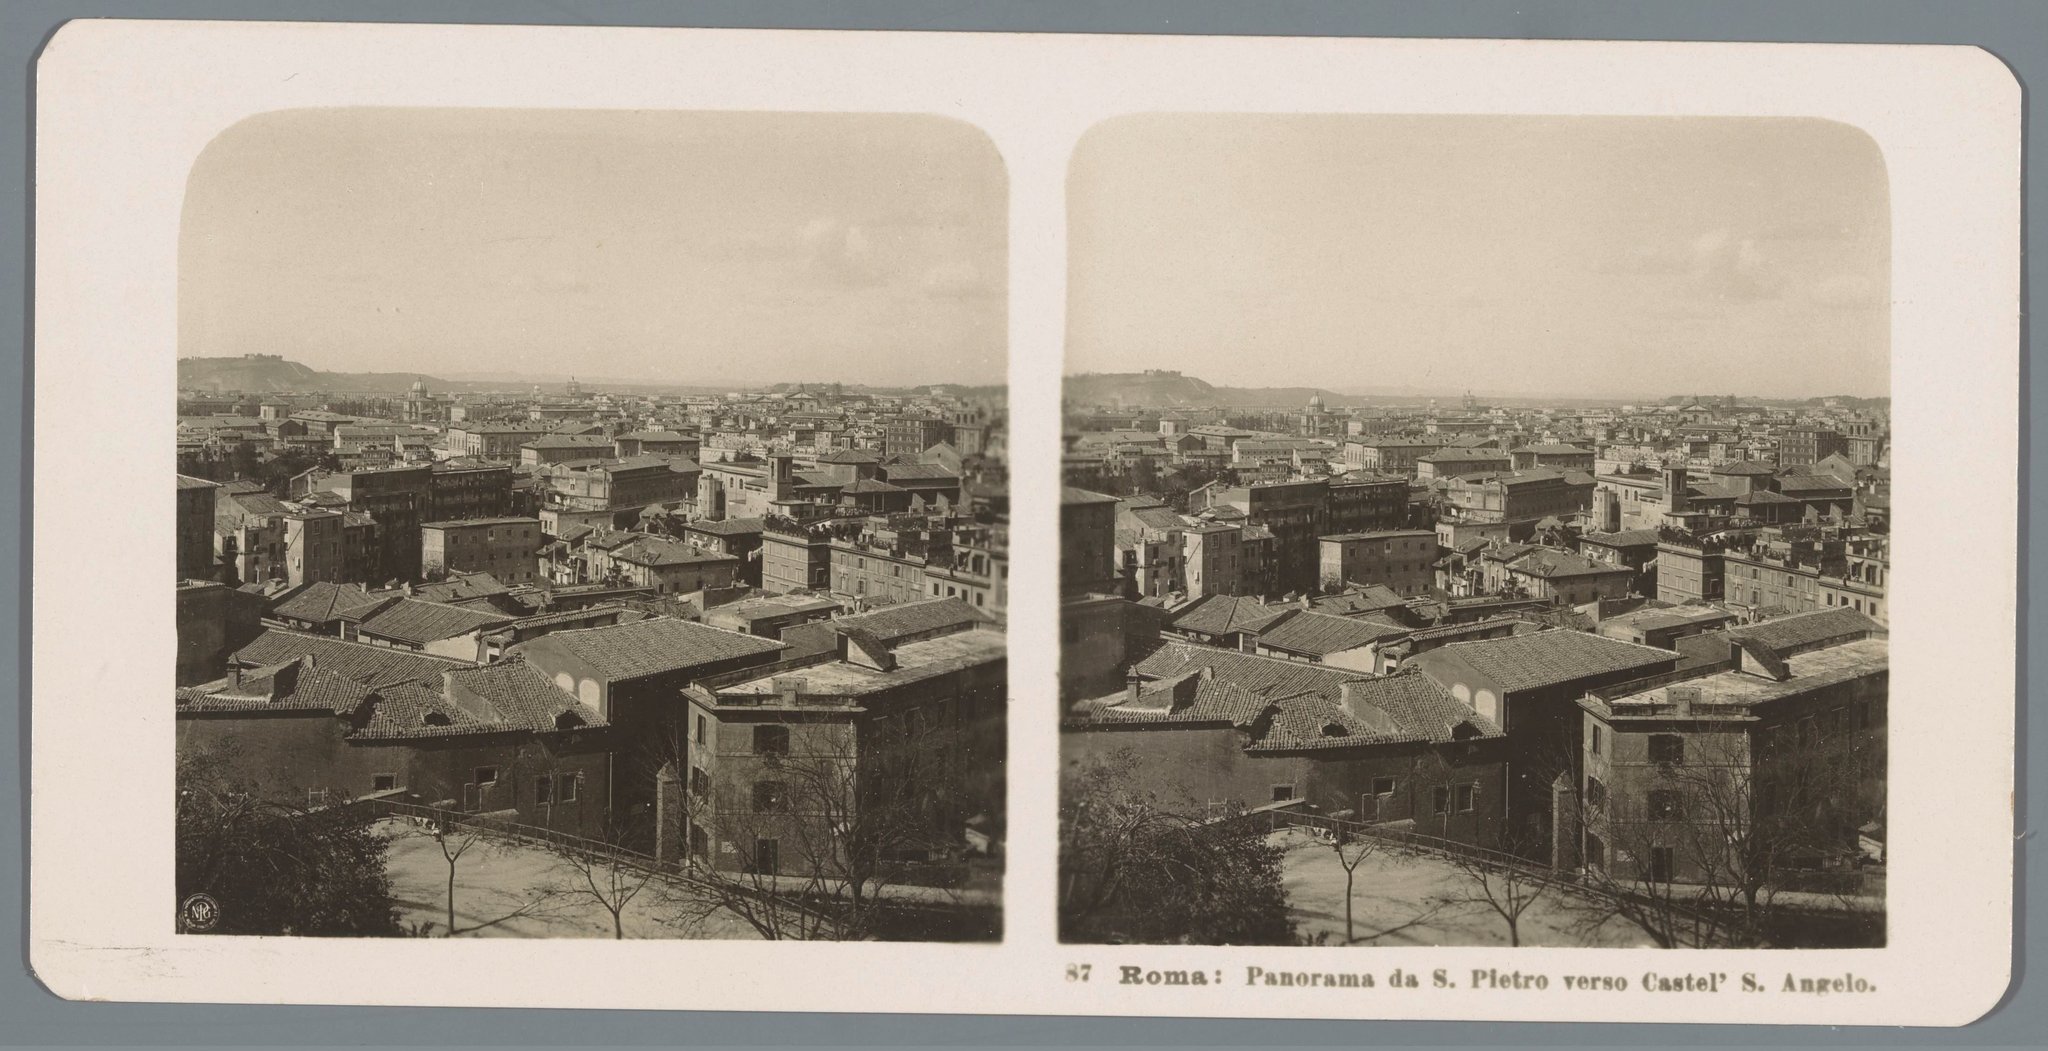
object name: stereograph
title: Gezicht op Rome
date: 1900-1910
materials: cardboard, photographic support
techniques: gelatin silver print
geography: rome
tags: city-view in general; 'veduta', rome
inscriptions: number: ‘87’, inscription: ‘NPG’